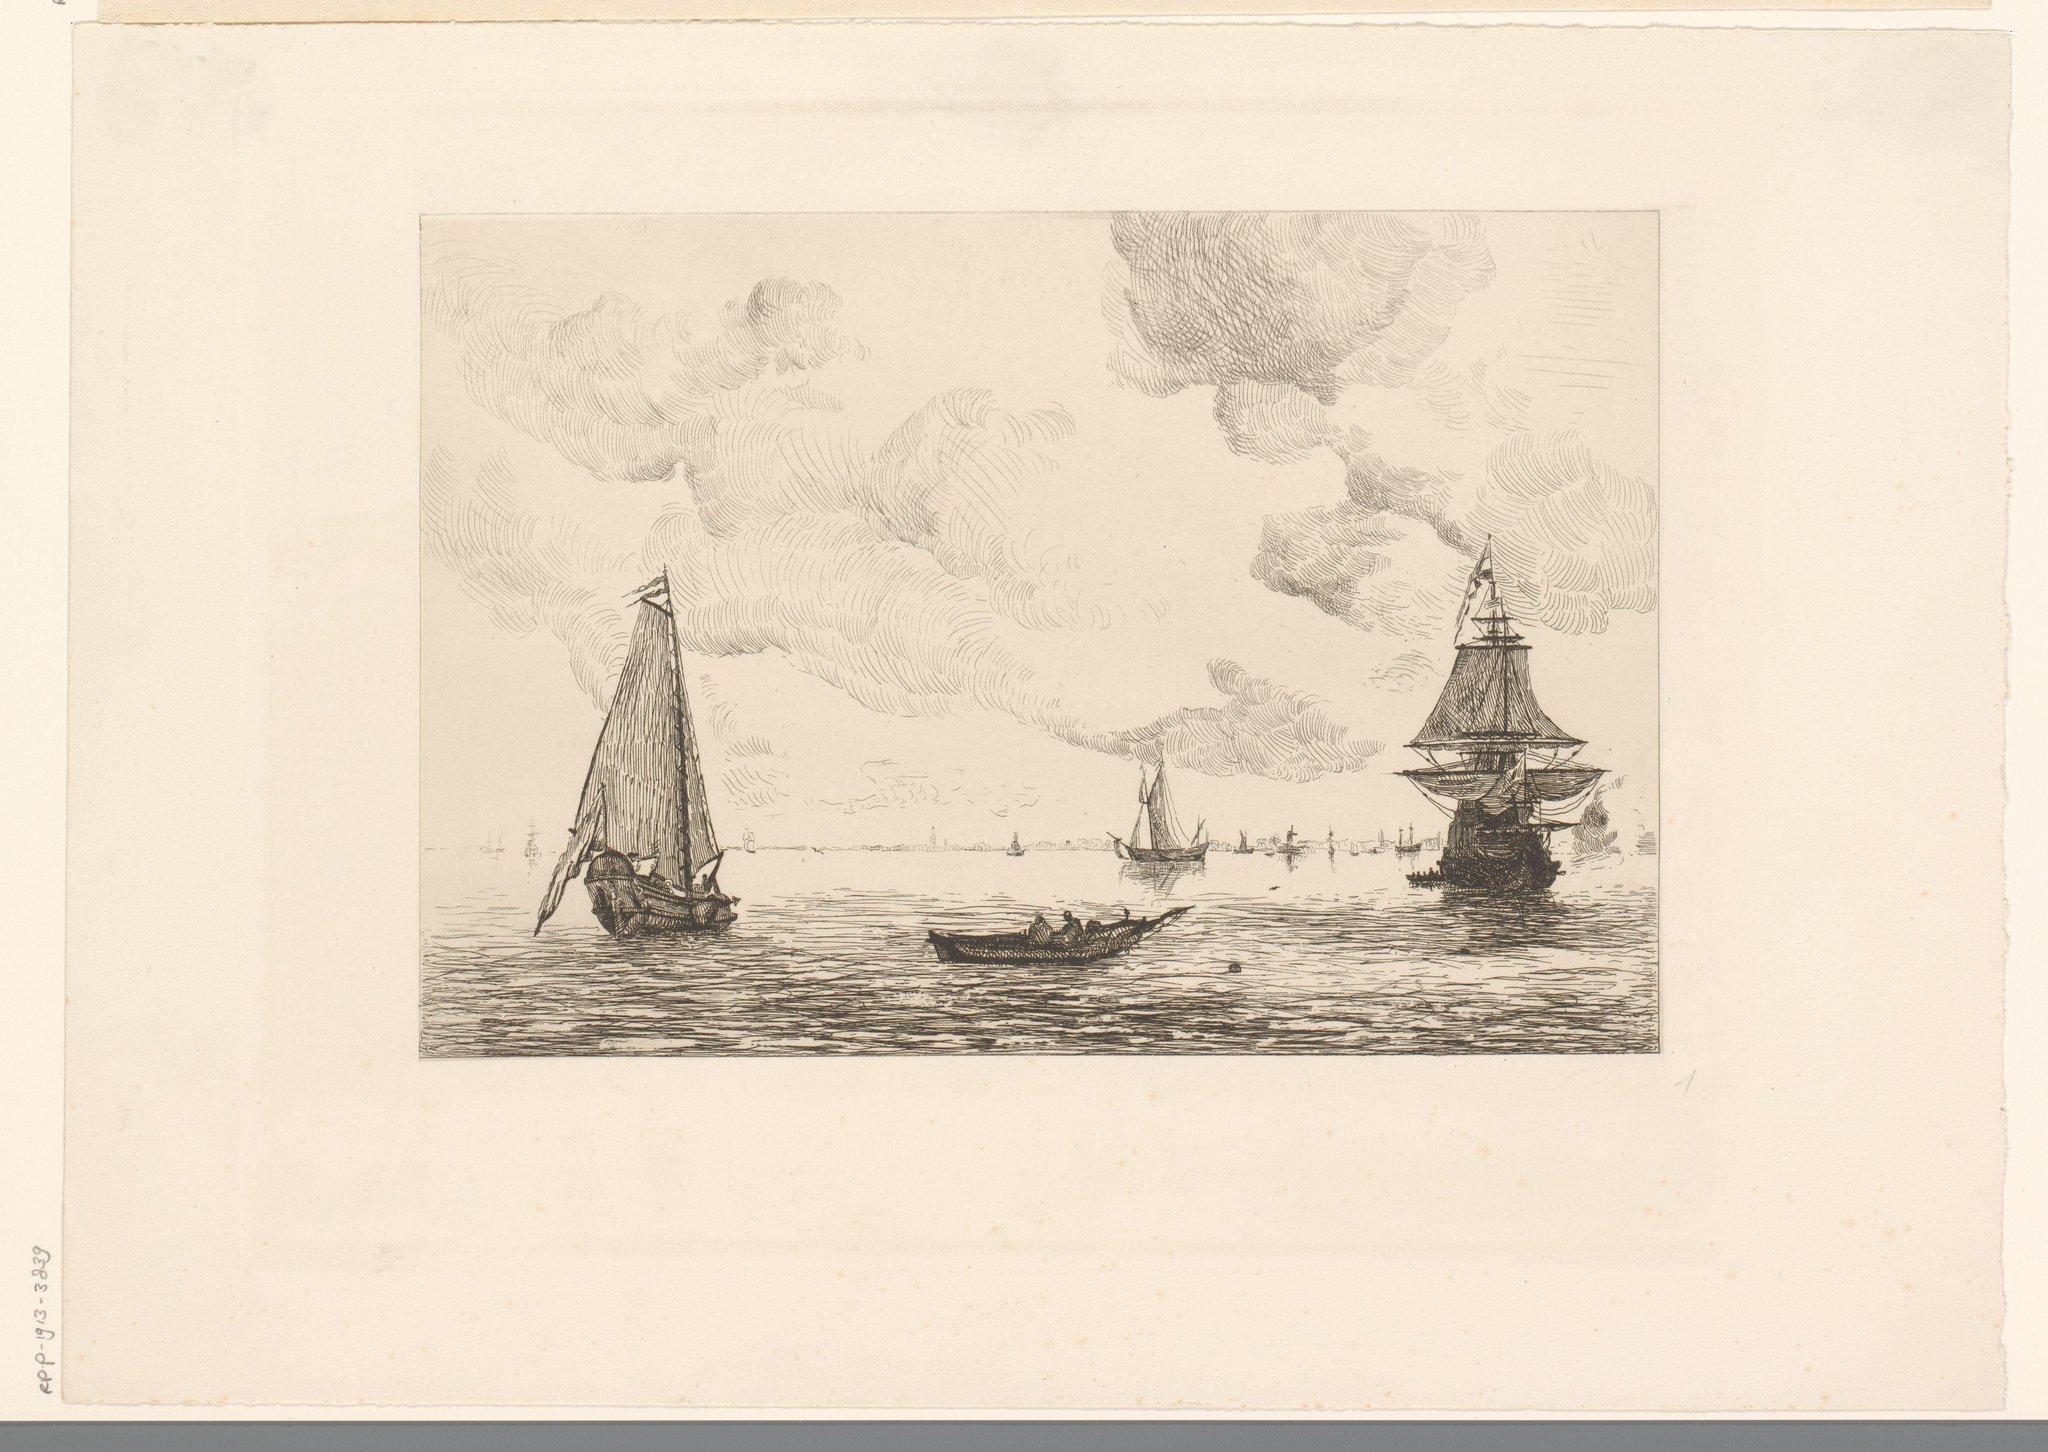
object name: print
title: Schepen liggen voor anker bij een rede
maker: piet verhaert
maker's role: print maker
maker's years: 1852-1908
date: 1887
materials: paper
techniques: etching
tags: sailing-ship, sailing-boat, landscapes with waters, waterscapes, seascapes (in the temperate zone), ship bound for the harbour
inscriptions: collector's mark: Lugt 2228